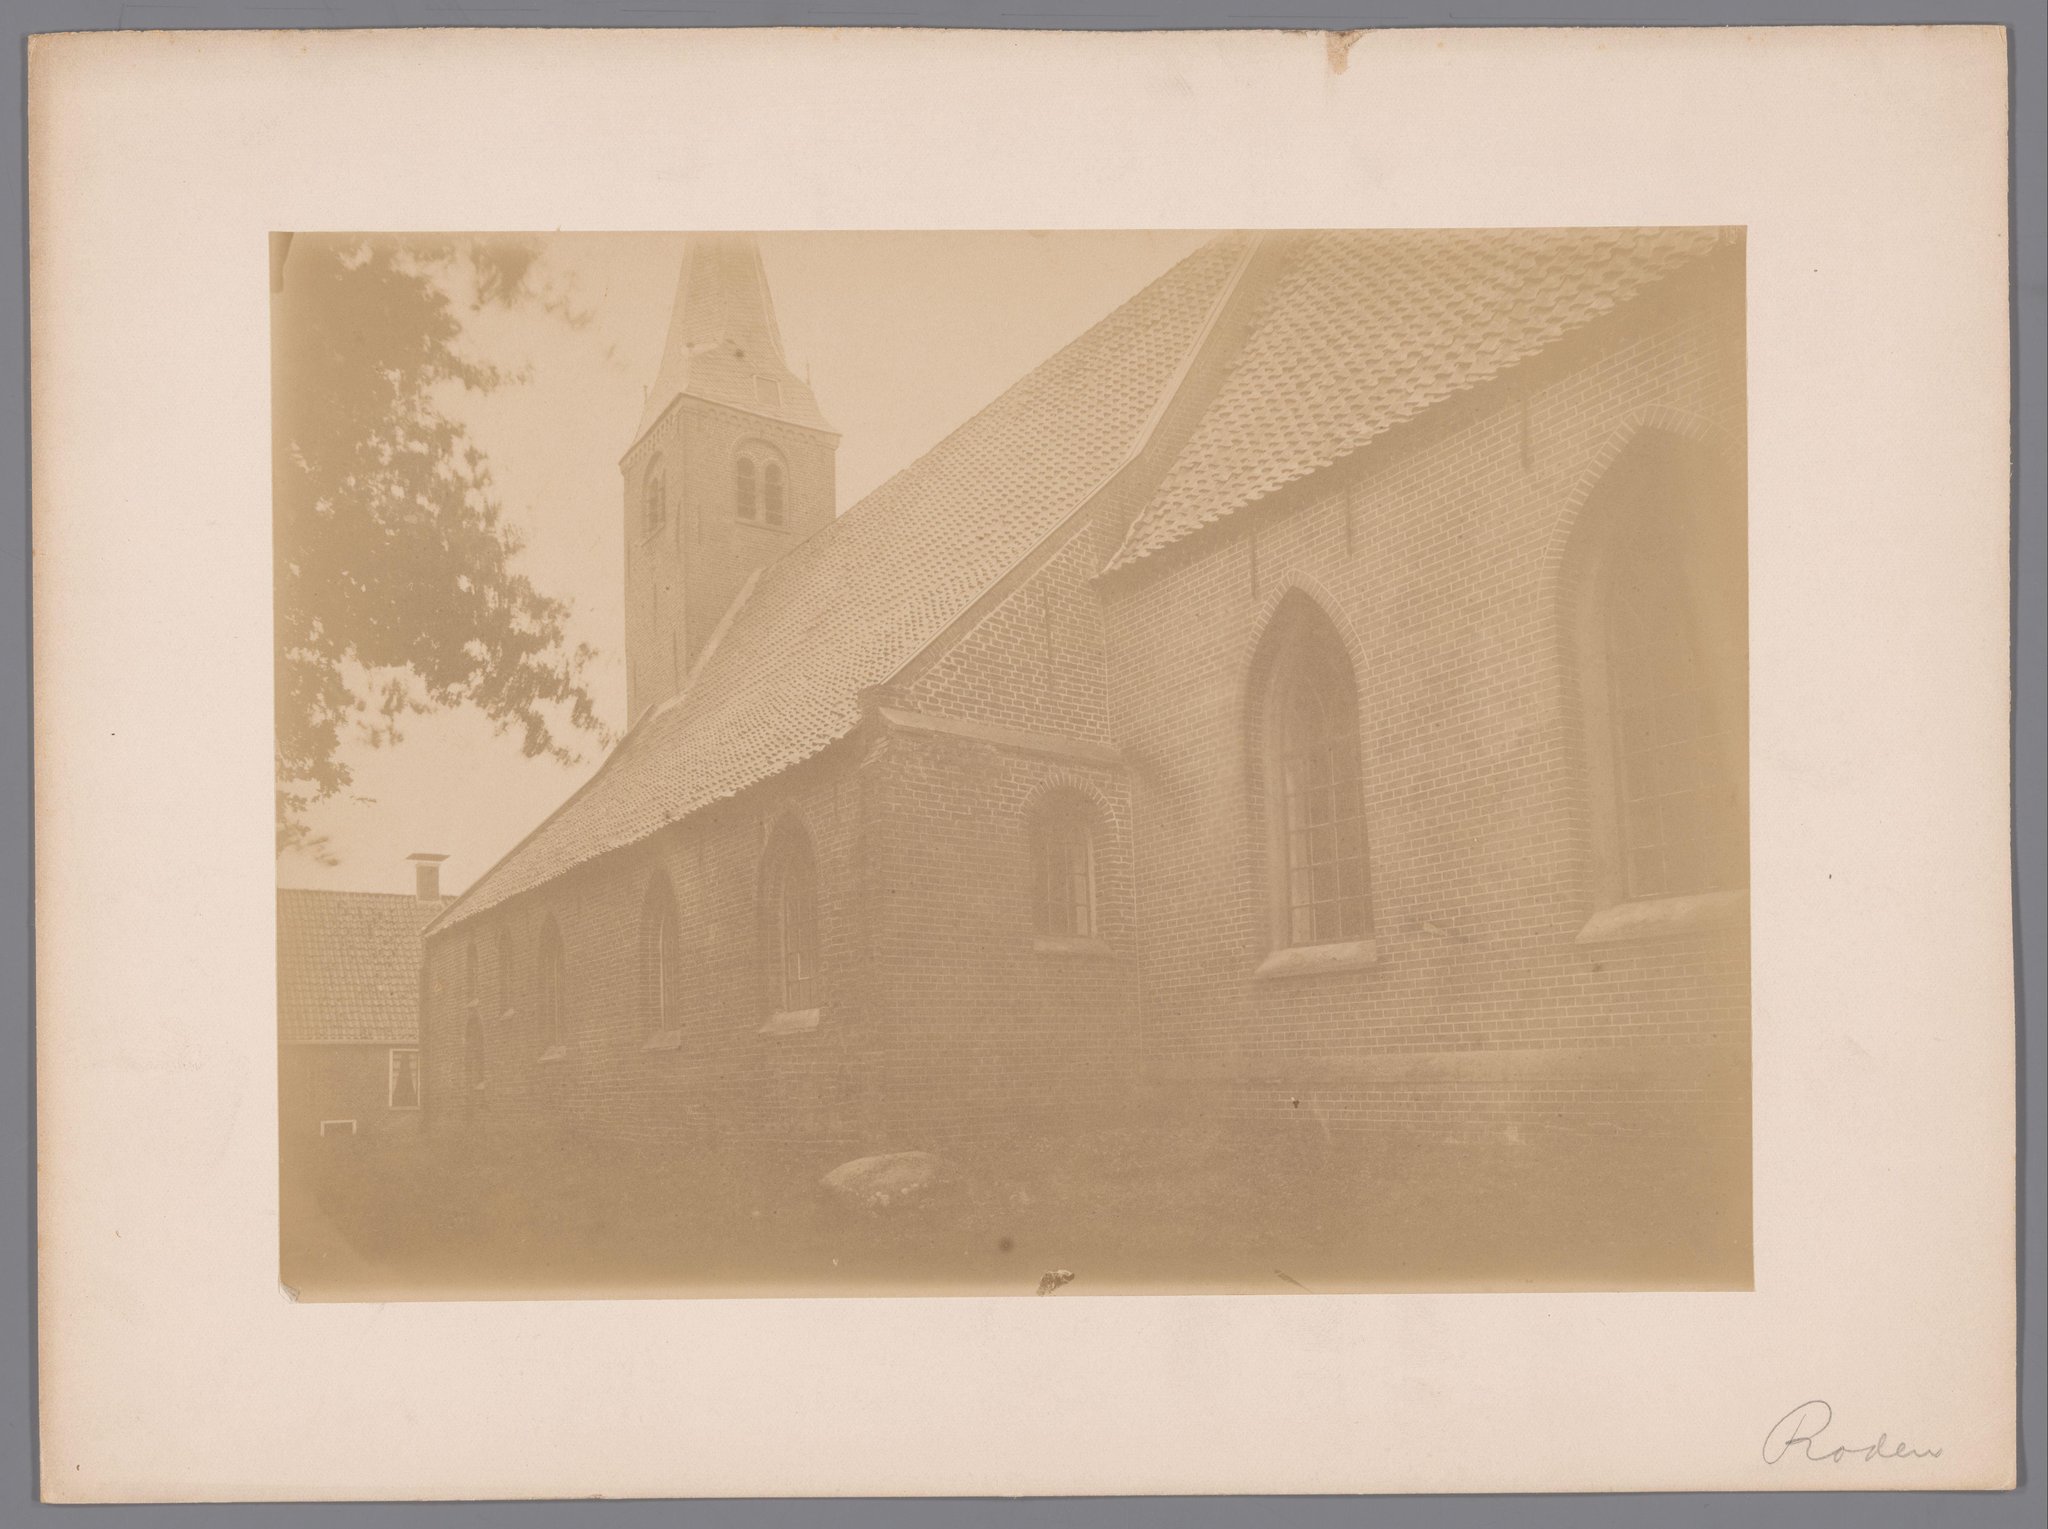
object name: photograph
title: Gezicht op de Mariakerk te Ruinen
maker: anoniem (monumentenzorg)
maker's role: fotograaf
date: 1898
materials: cardboard, photographic support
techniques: albumen print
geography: ruinen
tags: church (exterior)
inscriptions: annotation: ‘Kerk v/d N.H. gemeente te Ruinen (Drenthe)/ Aug 1898/ Ruinen’, annotation: ‘Ruinen’